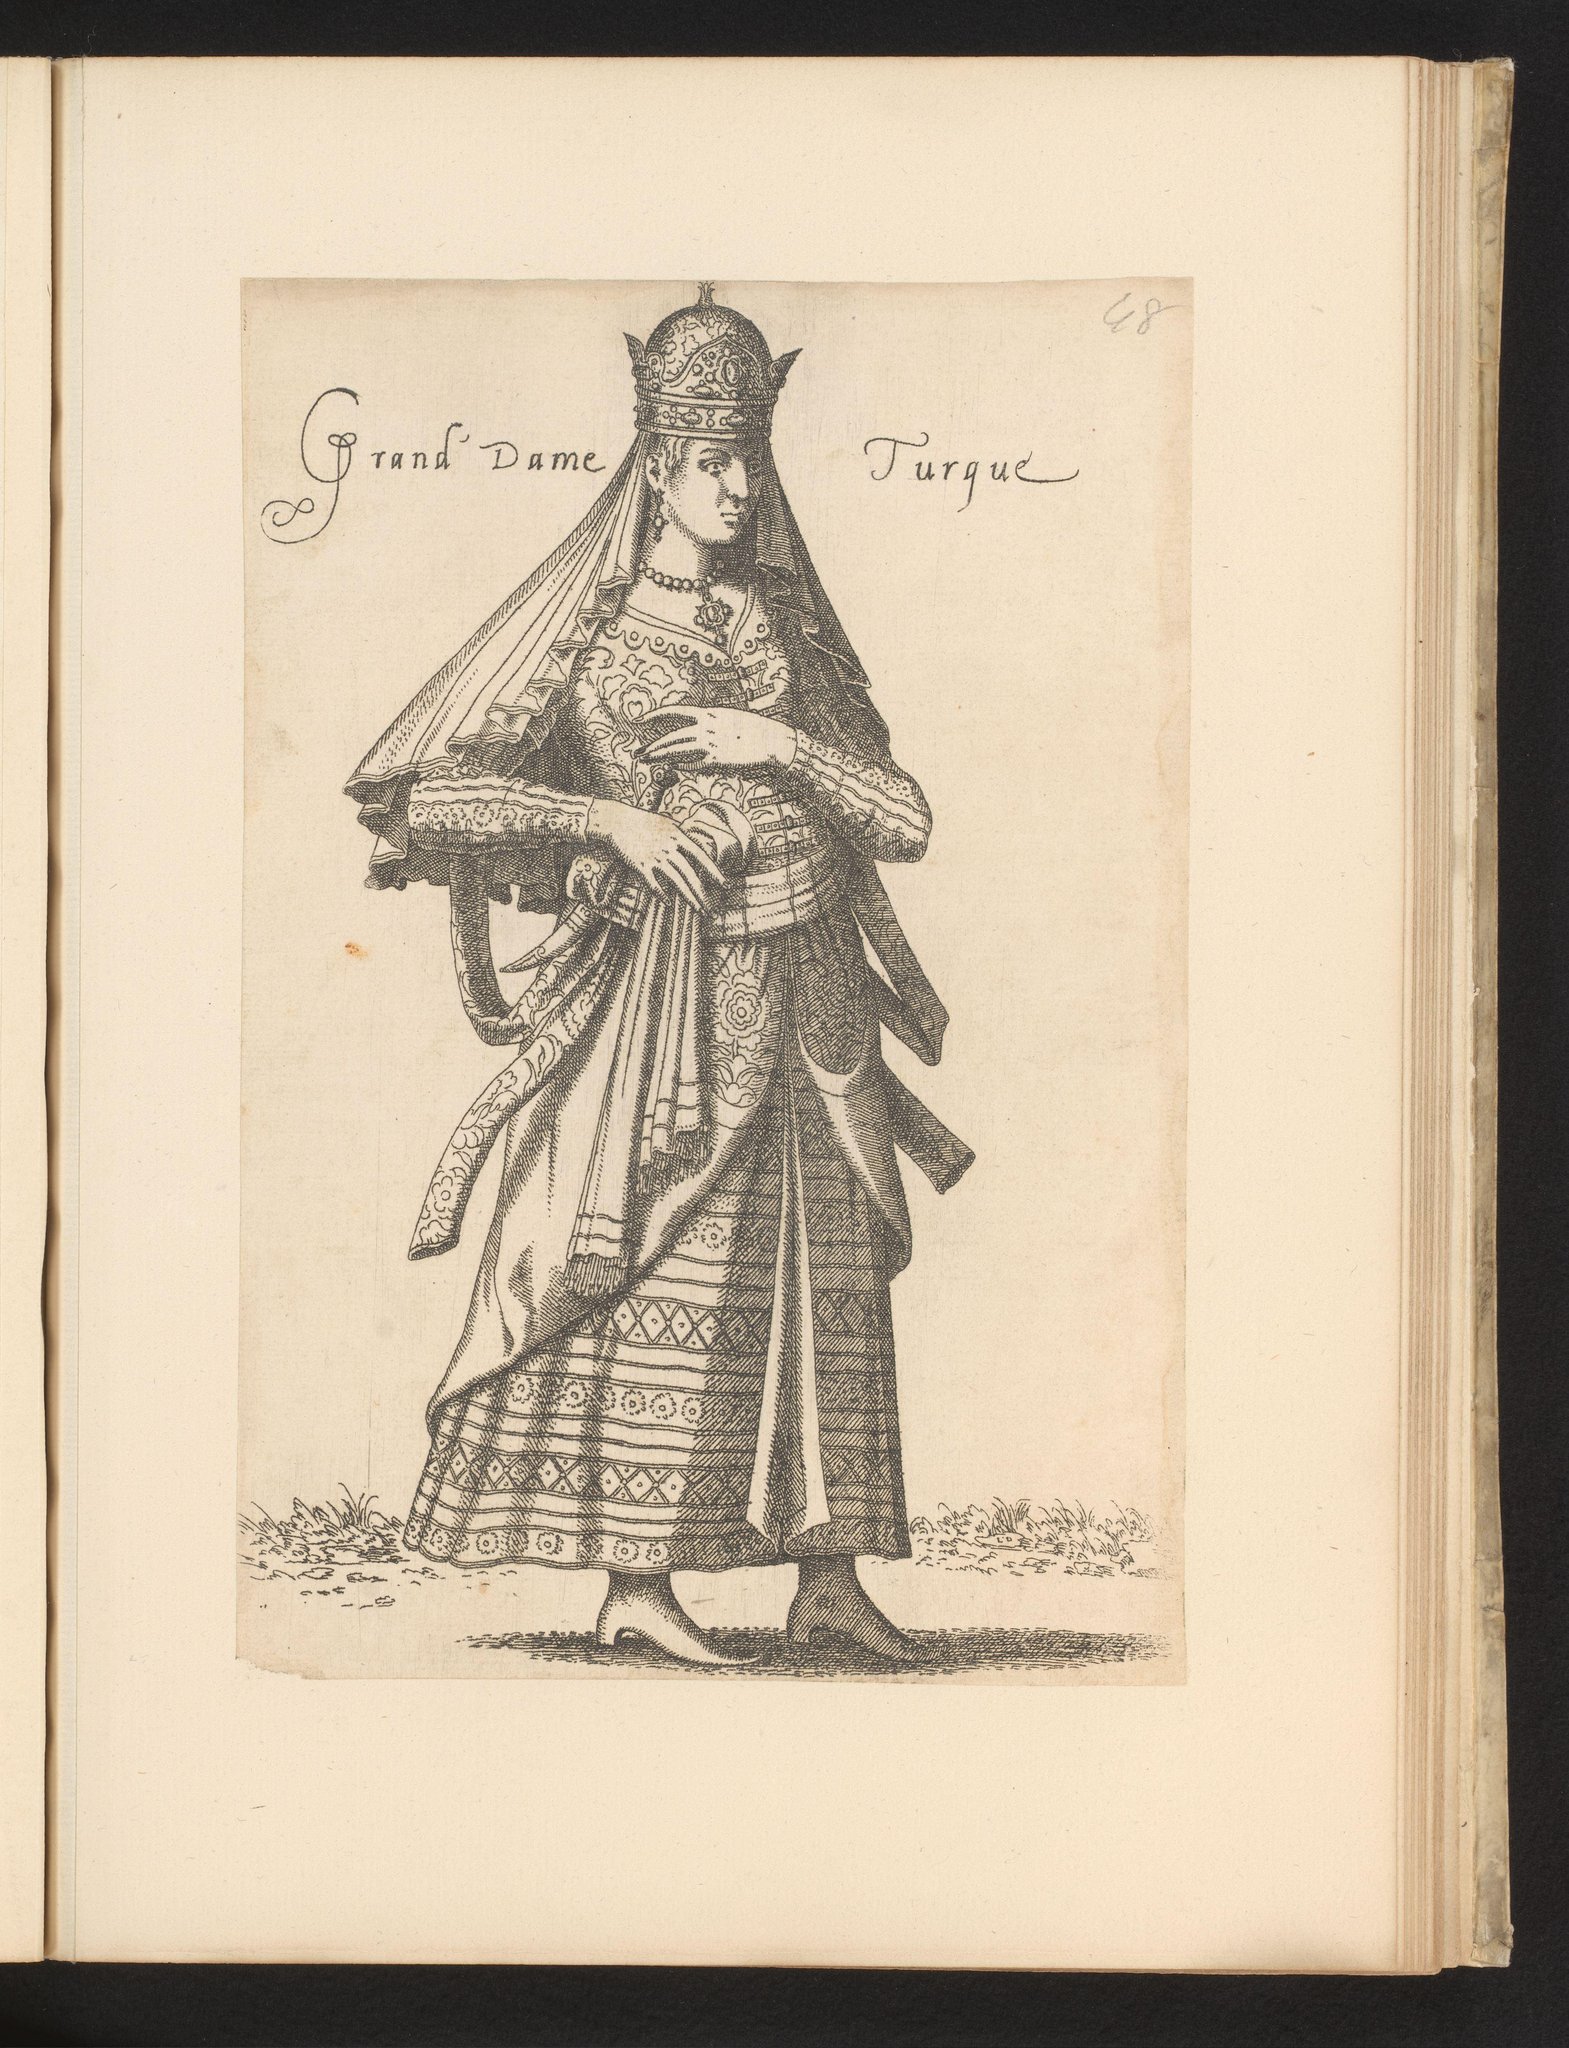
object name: album leaf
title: Turkse edelvrouw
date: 1555-1568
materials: paper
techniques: etching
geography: lyon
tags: folk costume, regional costume, nobility and patriciate; chivalry, knighthood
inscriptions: collector's mark: Lugt 2228, collector's mark: Lugt 2760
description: Prent uit: Nicolay, Nicolas de. Les quatre premiers livres des navigations et pérégrinations orientales, de N. de Nicolay, (...) Avec les figures au naturel tant d'hommes que de femmes selon la diversité des nations, & de leur port, maintien & habitz. Lyon: Guillaume (I) Rouille, 1568.